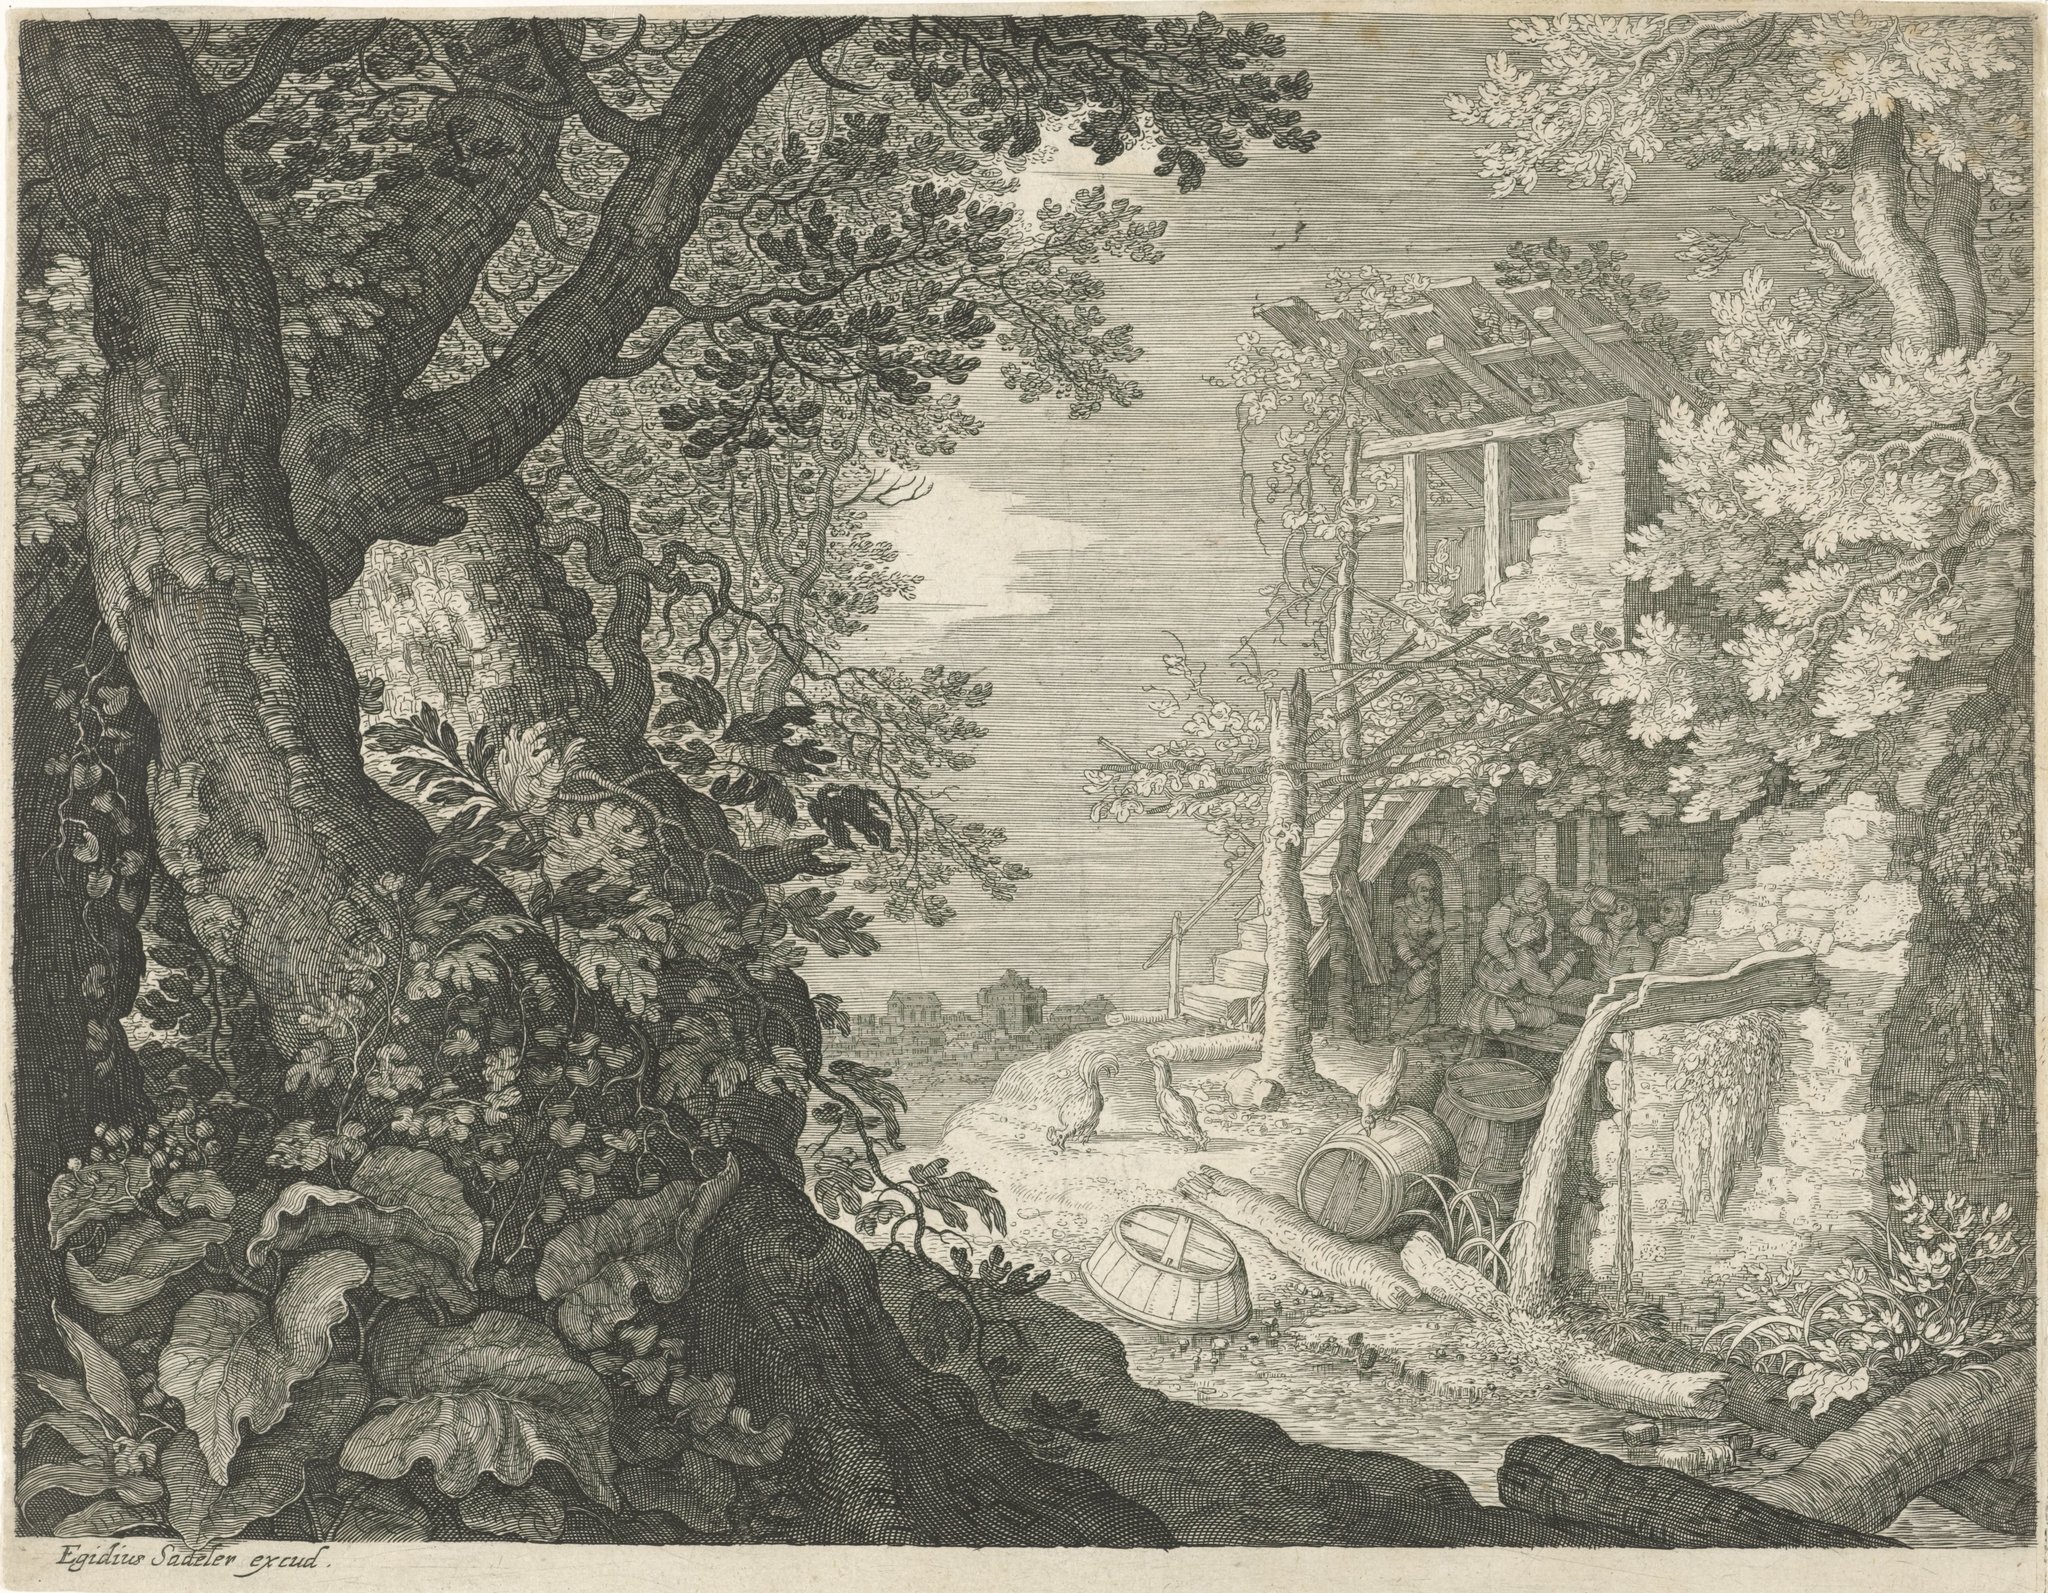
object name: print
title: Drinkende mannen in een herberg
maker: aegidius sadeler (ii)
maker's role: draughtsman, print maker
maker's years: 1568-1629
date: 1597-1629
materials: paper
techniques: engraving, etching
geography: prague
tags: inn, coffee-house, public house, etc., forest, wood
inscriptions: collector's mark: Lugt 240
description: Drinkende mannen bij de trap van een bouwvallige herberg aan de rand van een bos. Linksvoor een paar bomen. De vijfde prent in een zesdelige reeks met landschappen.